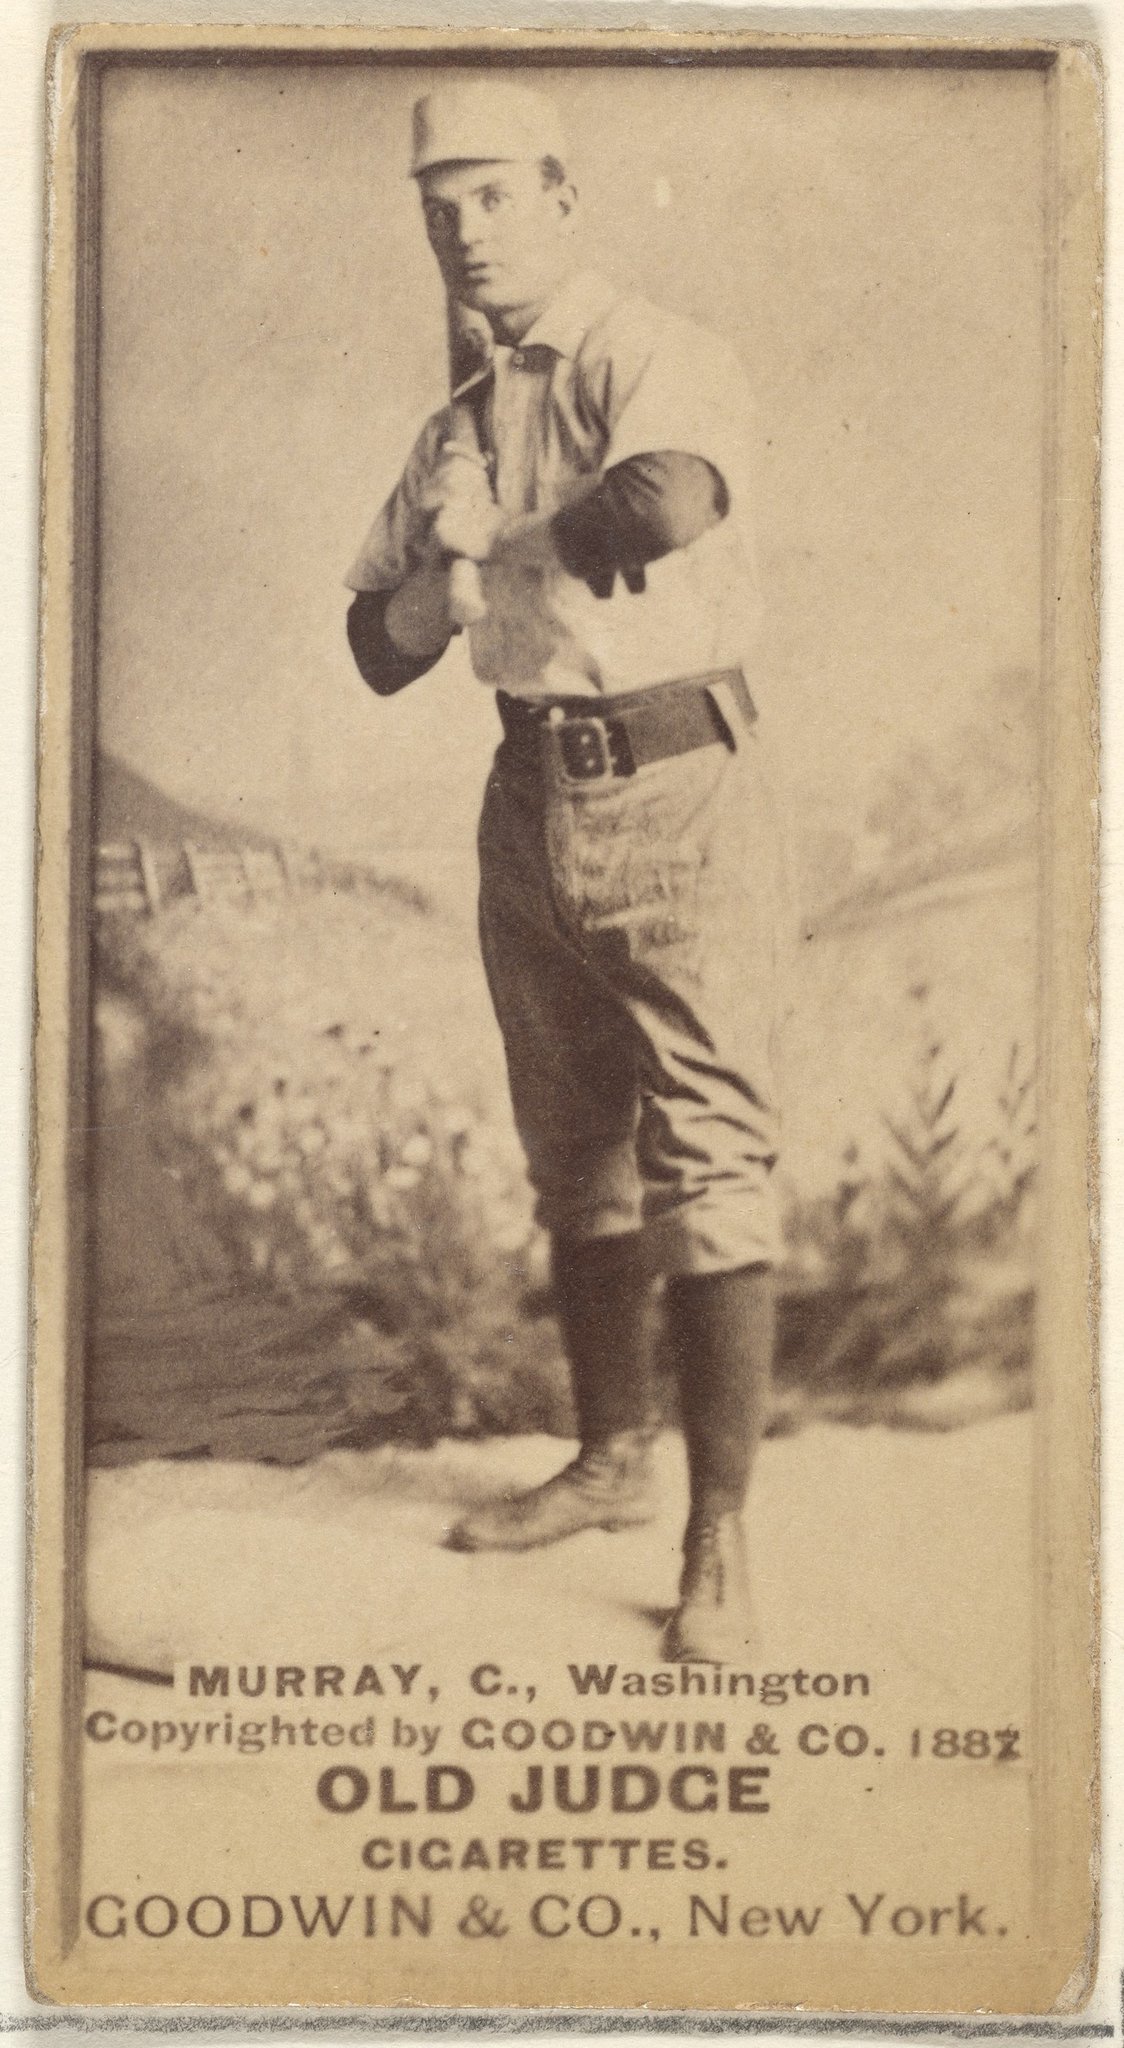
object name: baseball card, photograph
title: Jeremiah J. "Miah" Murray, Catcher, Washington Nationals, from the Old Judge series (N172) for Old Judge Cigarettes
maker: goodwin & company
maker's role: publisher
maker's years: 1850-1950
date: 1887-1890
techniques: albumen silver print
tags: men,portraits,baseball,athletes